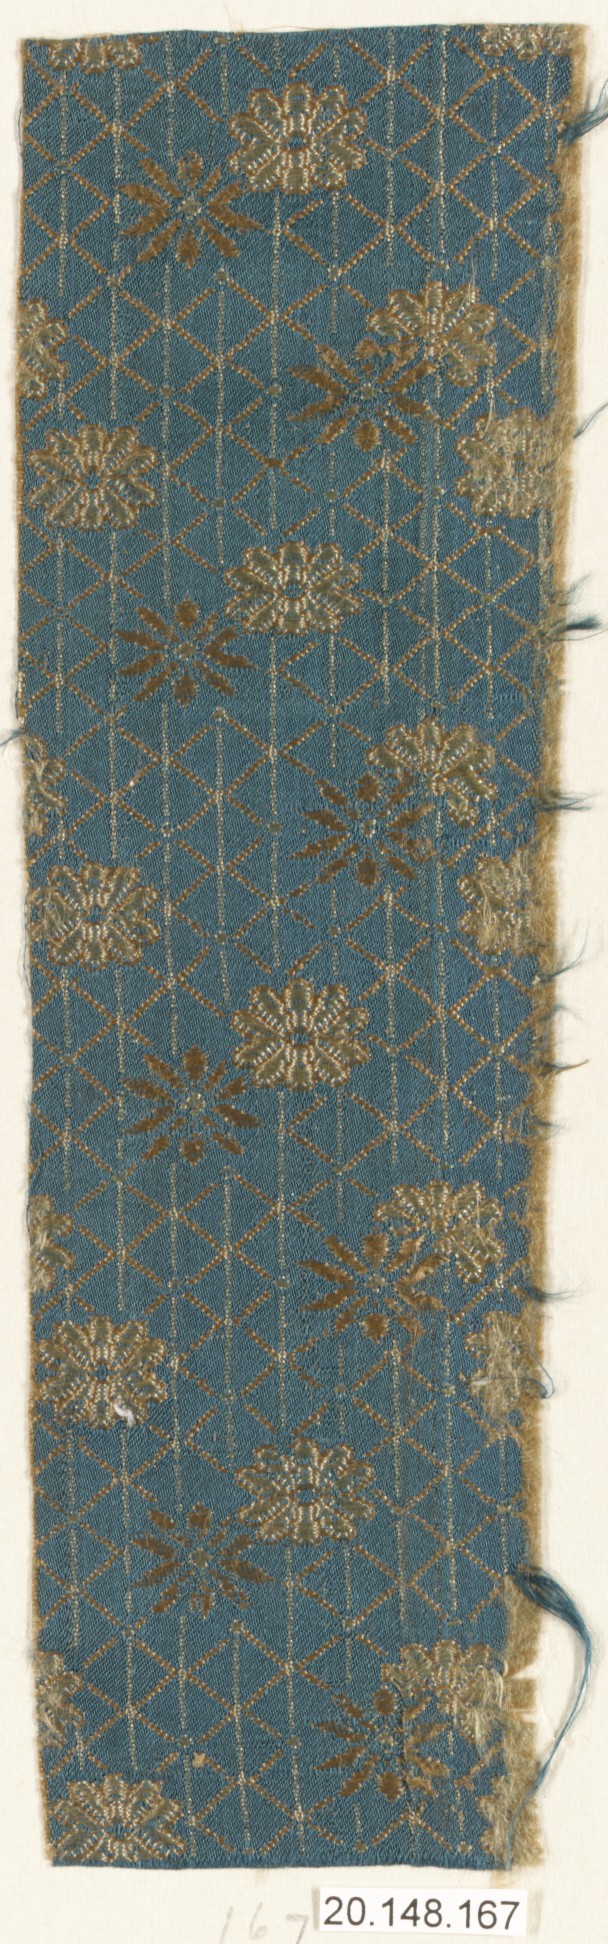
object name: piece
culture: japanese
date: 1601-1700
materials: silk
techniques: compound weave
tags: flowers